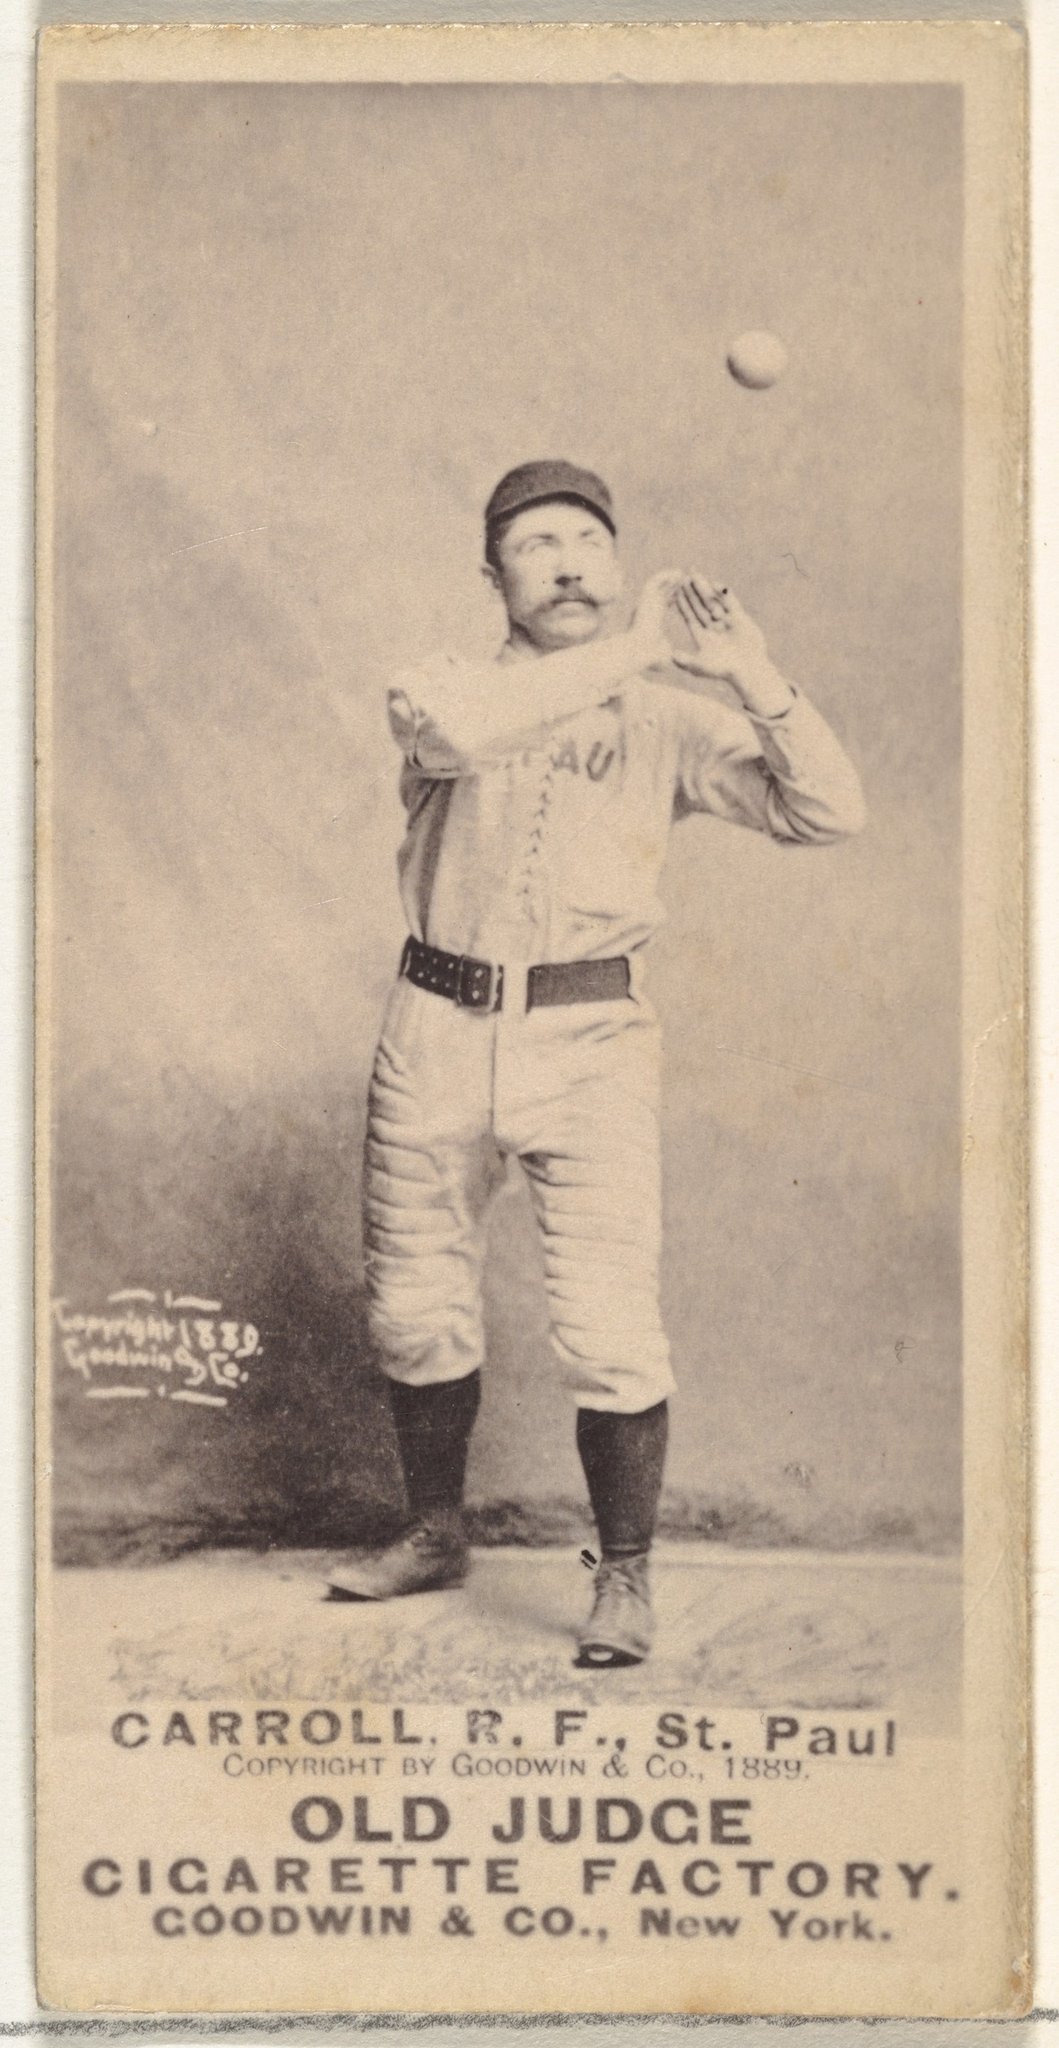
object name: baseball card, photograph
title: John E. "Scrappy" Carroll, Right Field, St. Paul Apostles, from the Old Judge series (N172) for Old Judge Cigarettes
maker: goodwin & company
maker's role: publisher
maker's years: 1850-1950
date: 1889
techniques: albumen silver print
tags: men,portraits,baseball,athletes